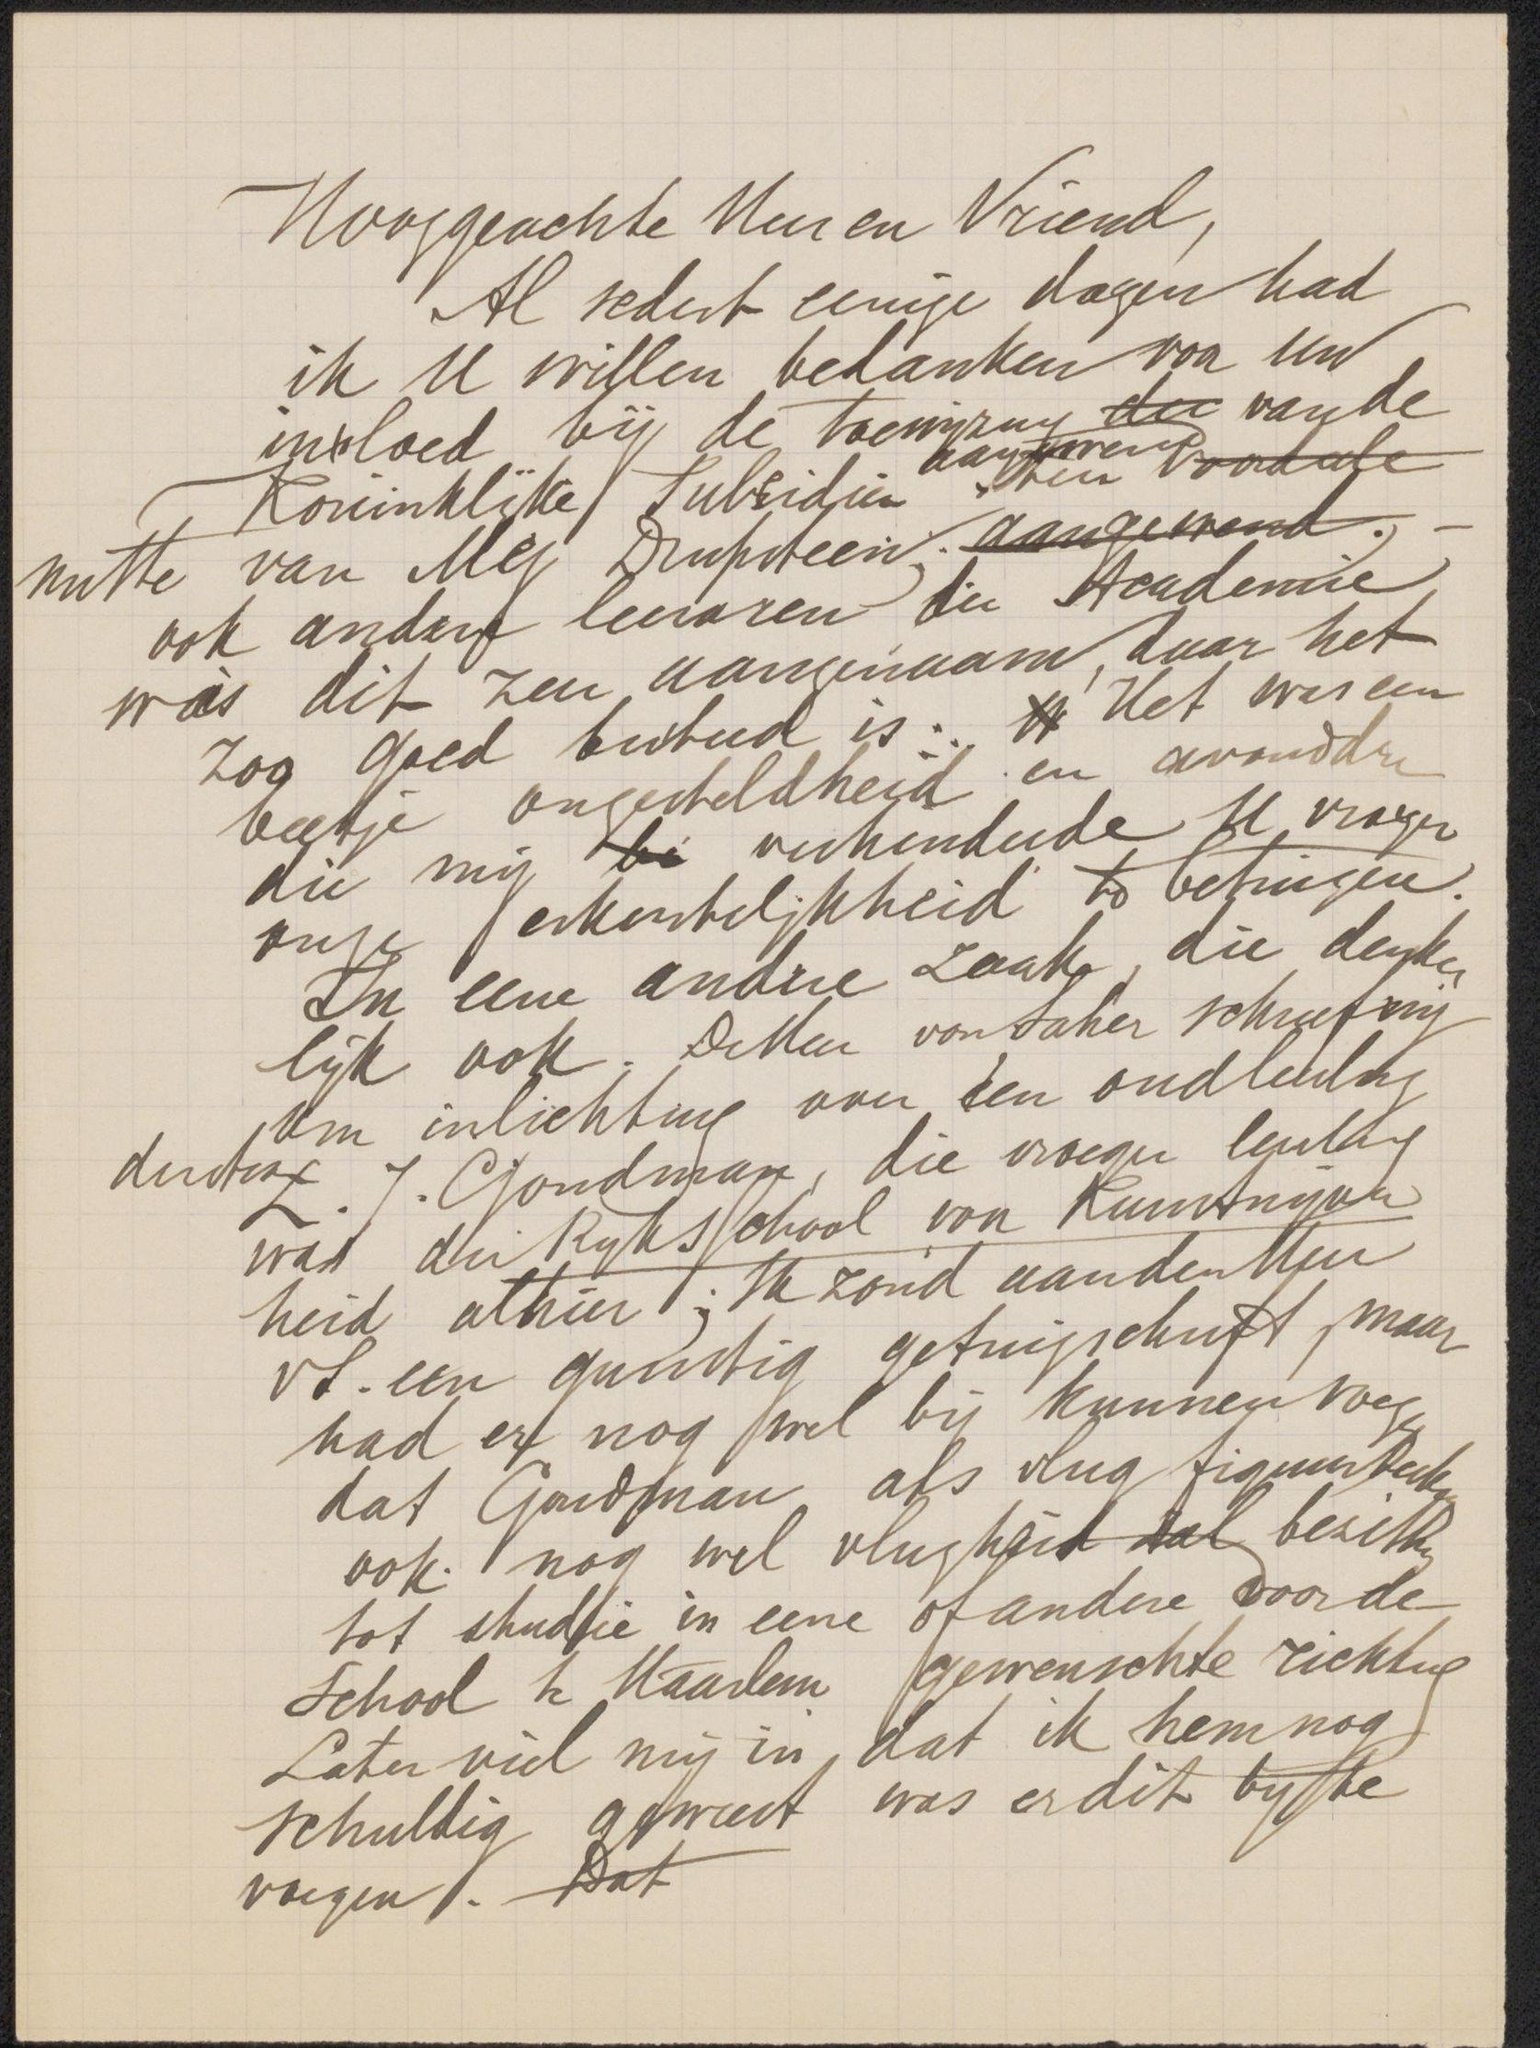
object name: letter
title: Conceptbrief aan anoniem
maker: august allebé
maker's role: draughtsman, print maker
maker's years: 1838-1927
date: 1848-1927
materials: ink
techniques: pen, writing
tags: wilhelmina drupsteen, brussels, louis goudman, haarlem, eduard august von saher, money